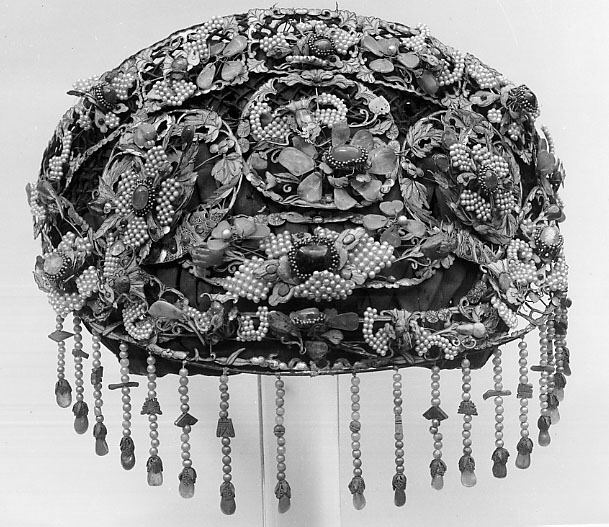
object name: headdress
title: Manchu Woman's Headdress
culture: chinese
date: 1767-1800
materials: feather, pearl, stone